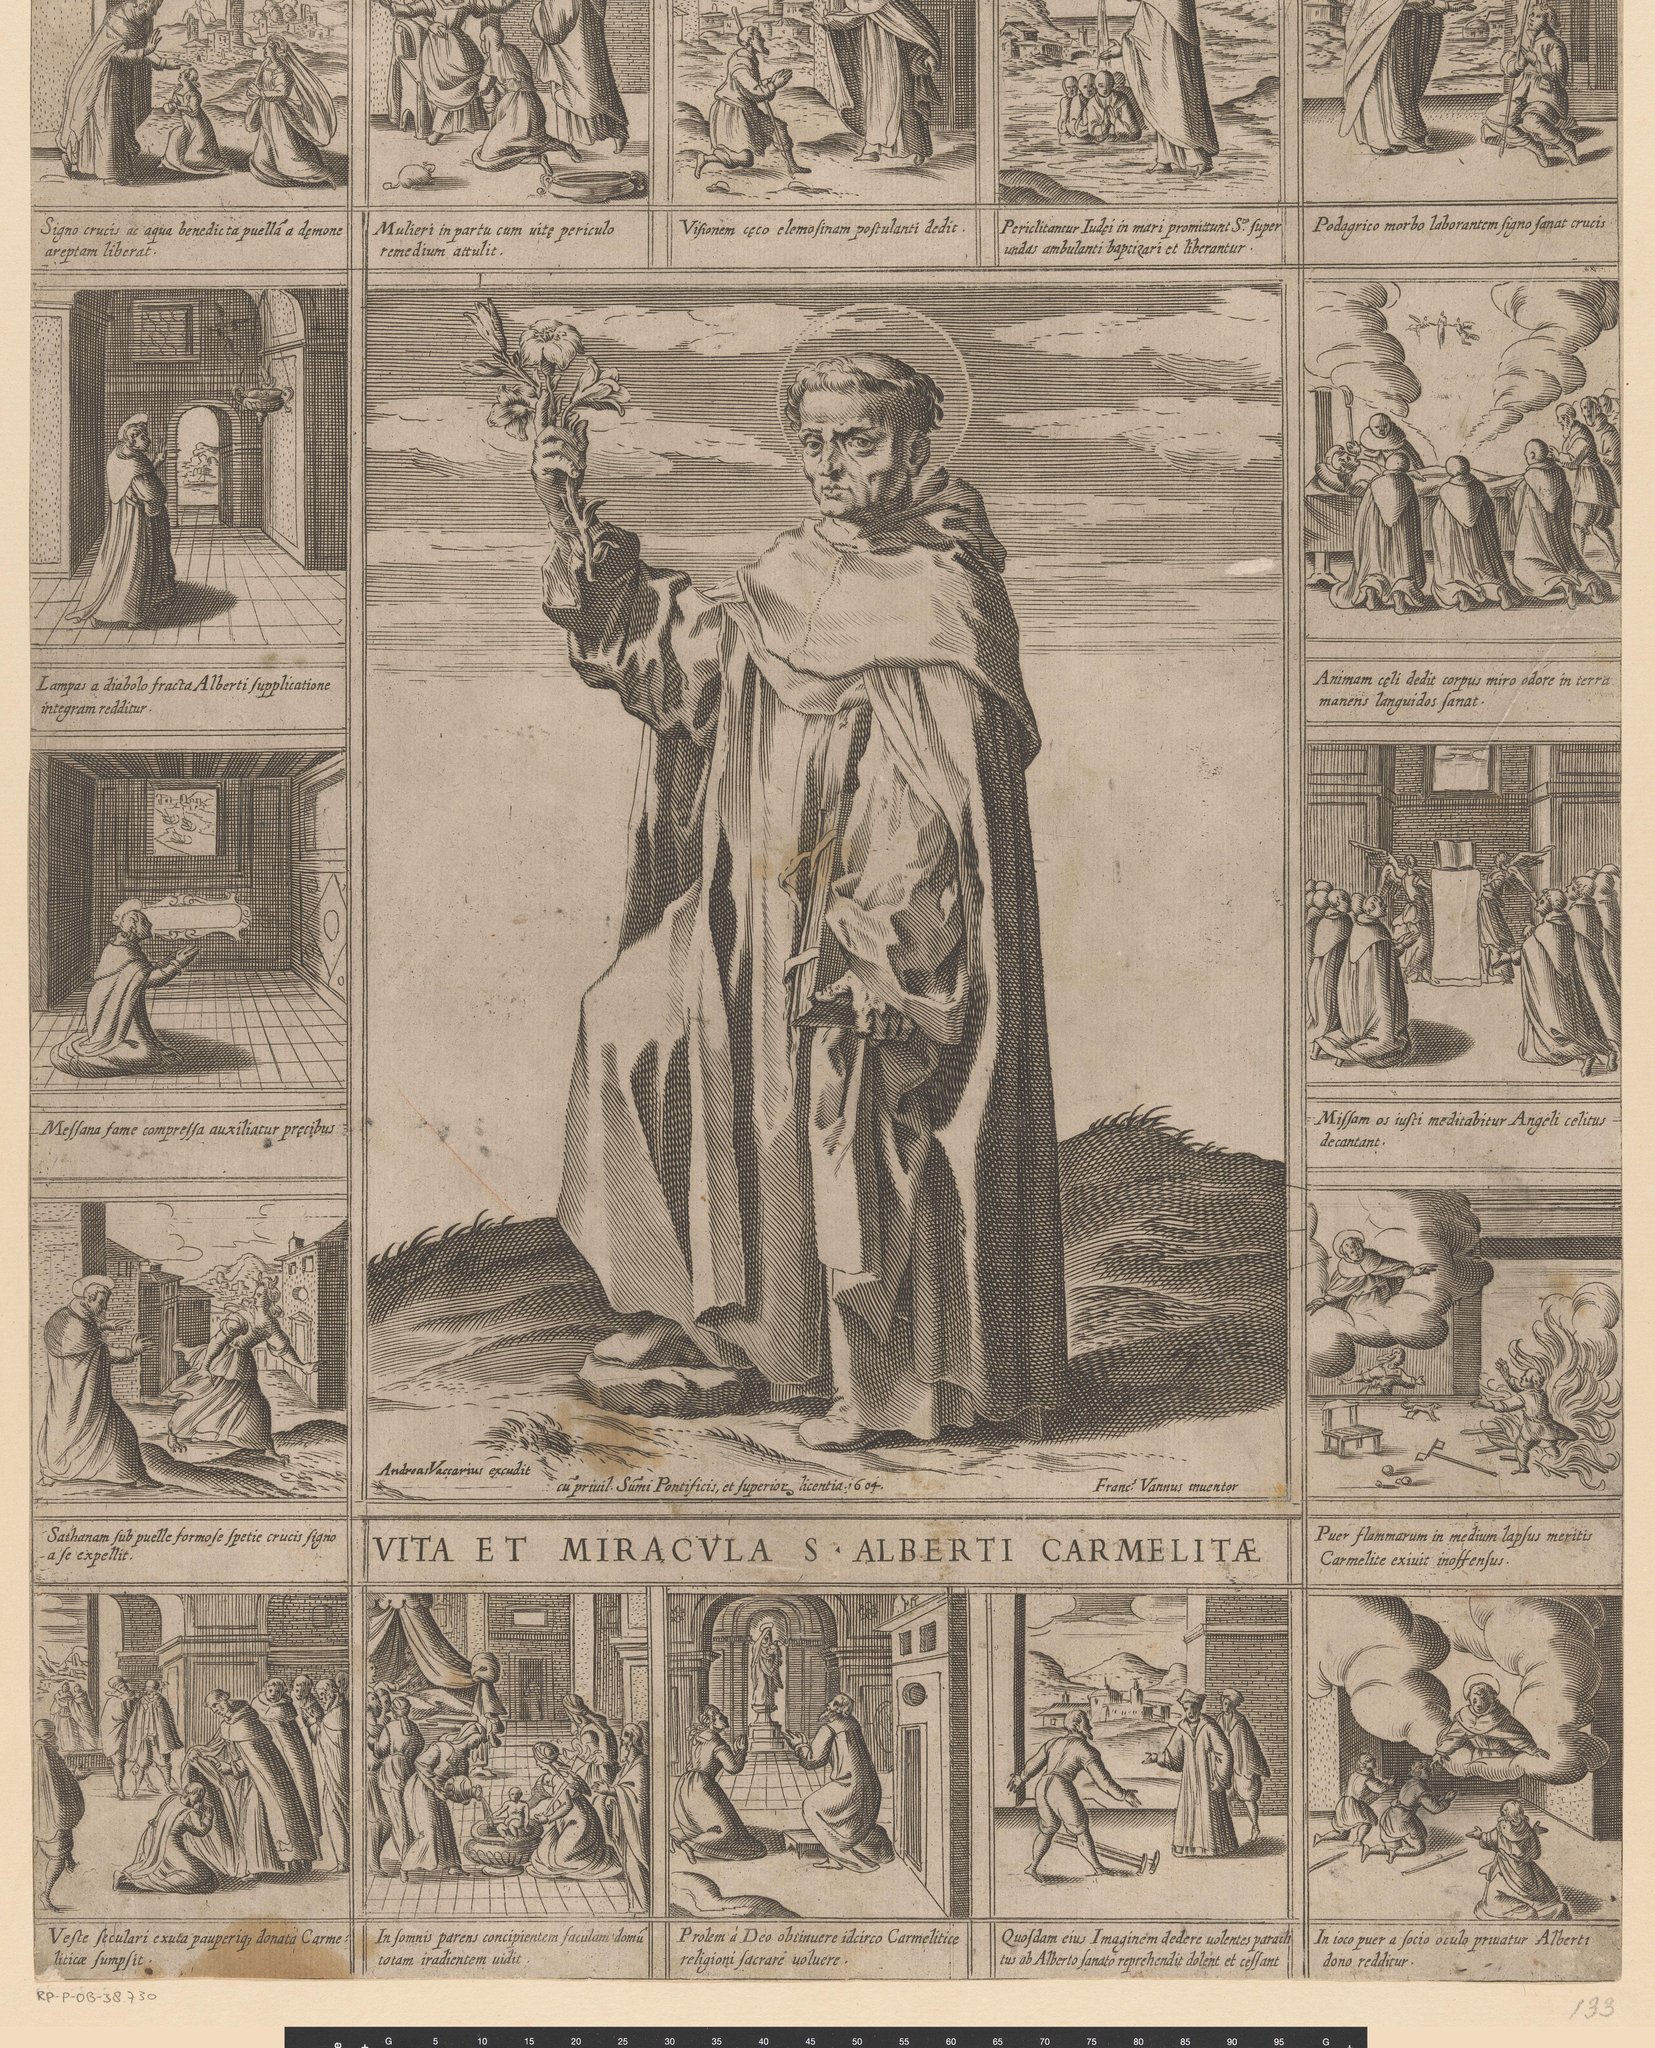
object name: print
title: Heiligenlevens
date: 1604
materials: paper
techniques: engraving, etching, intaglio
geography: italy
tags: male saints (with name)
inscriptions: collector's mark: Lugt 240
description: Deze prent maakt deel uit van een door Andrea Vaccari uitgegeven serie, bestaande uit ten minste tien prenten met voorstellingen van heiligen, omringd door kleinere voorstellingen met scènes uit het leven van desbetreffende heilige.